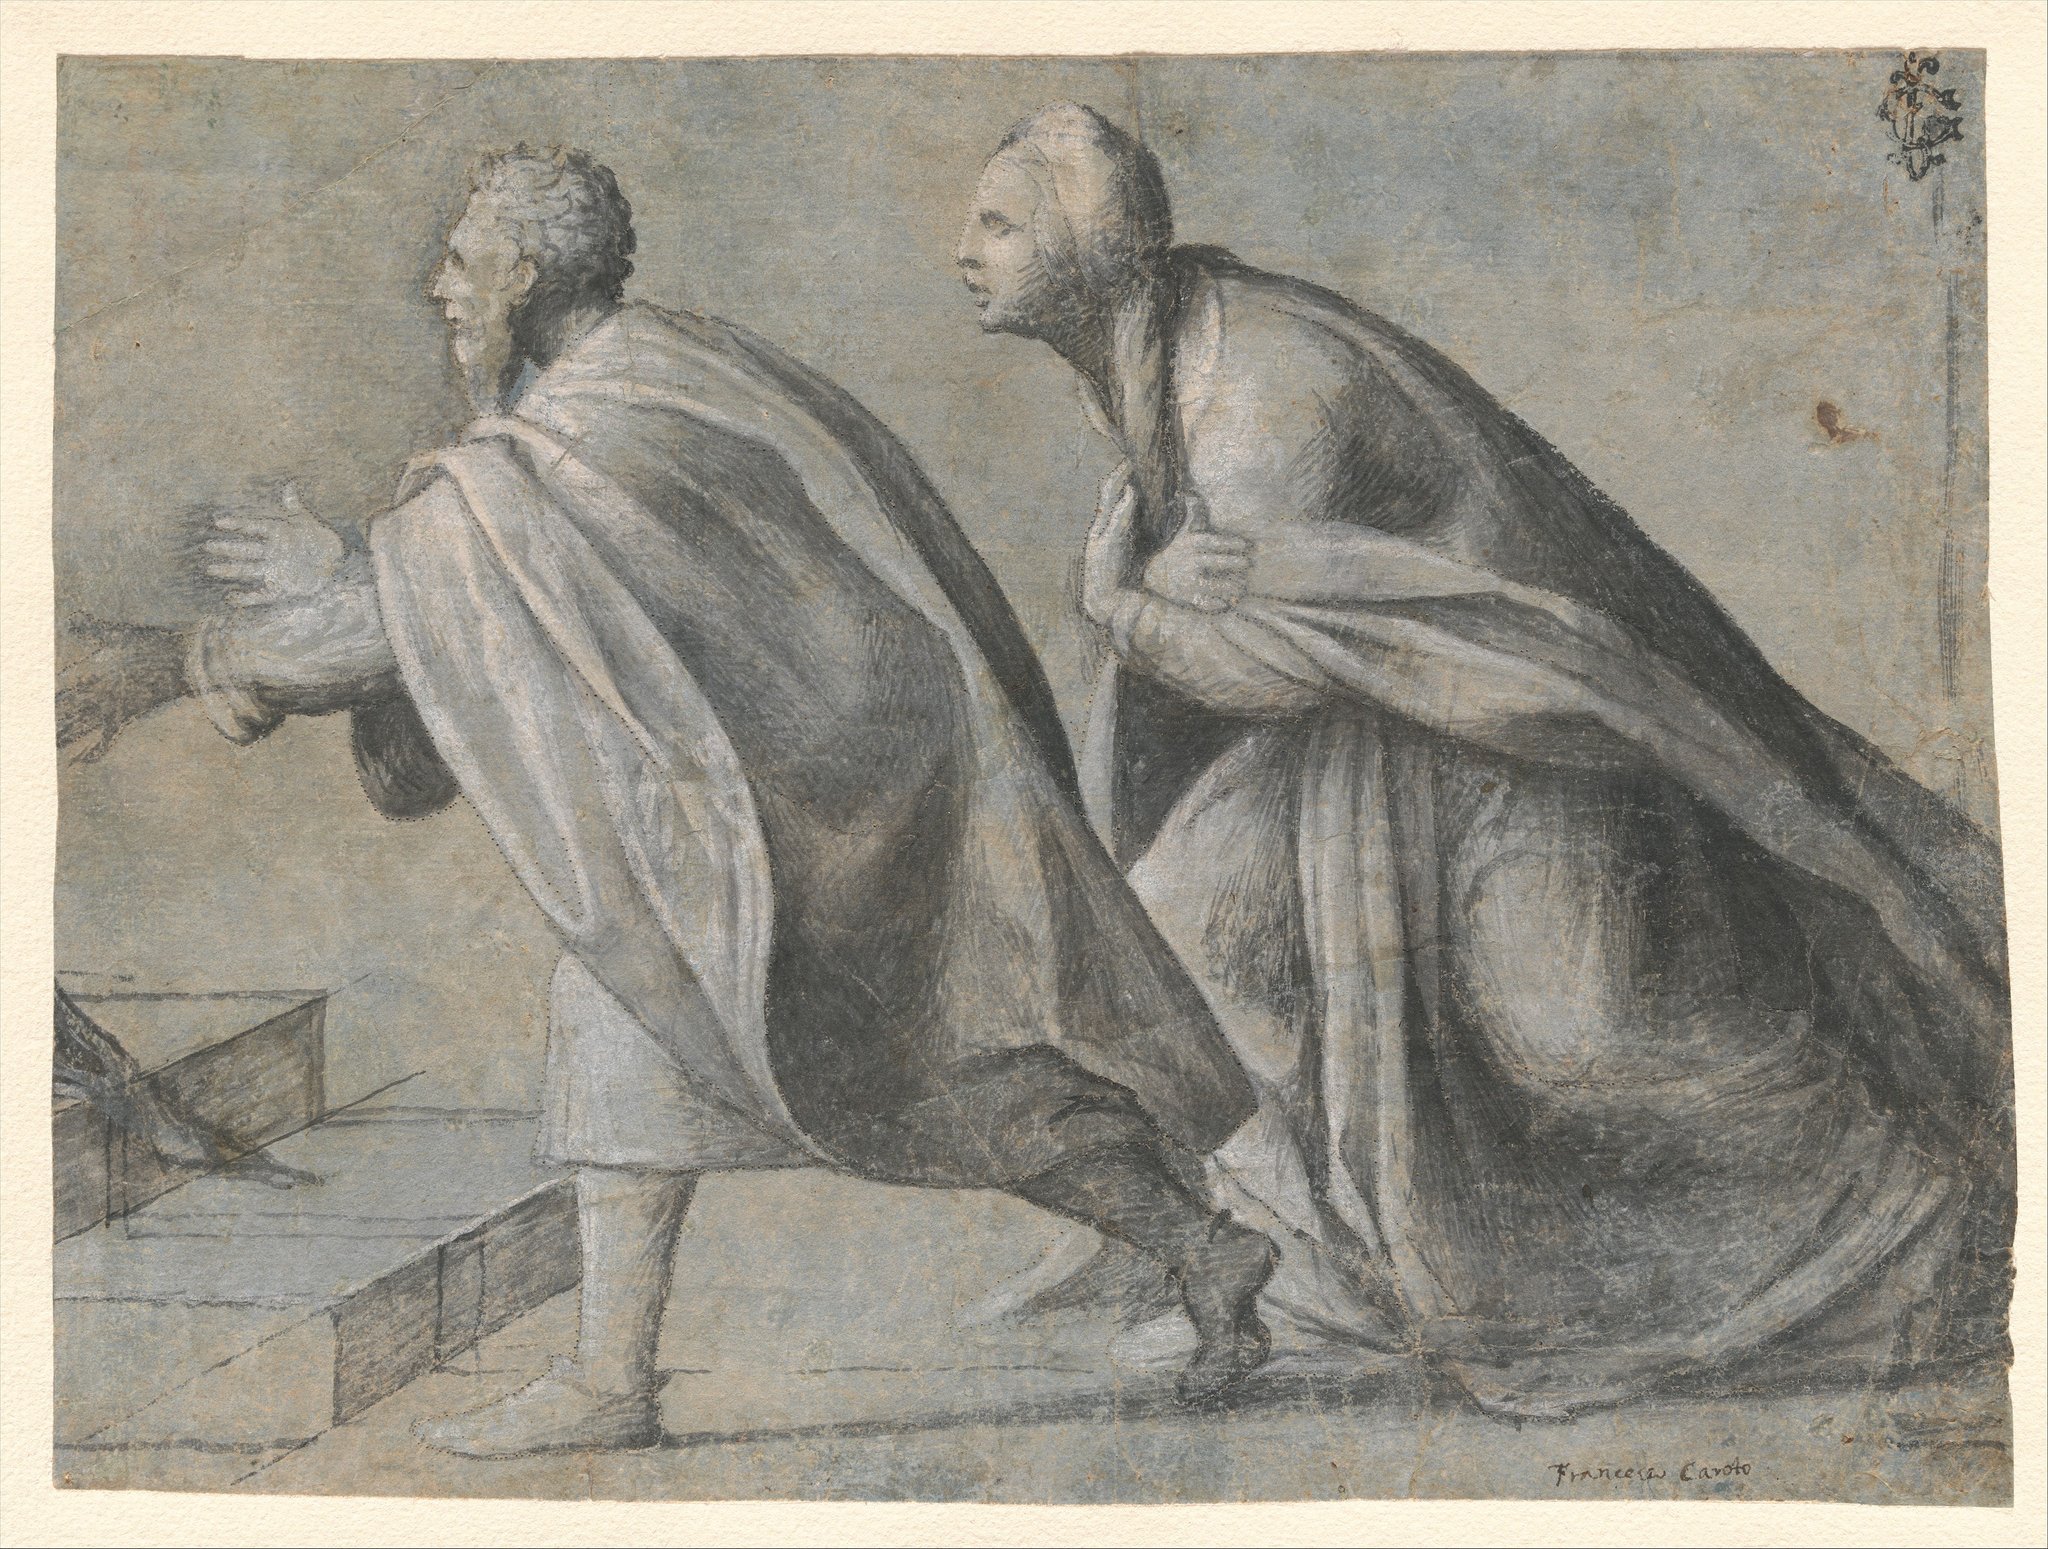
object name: drawing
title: Man and Woman Striding Toward the Left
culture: italian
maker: giovanni francesco caroto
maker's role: artist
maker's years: 1480-1555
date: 1501-1533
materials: ink, paper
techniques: brush, heightening, wash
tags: men,women